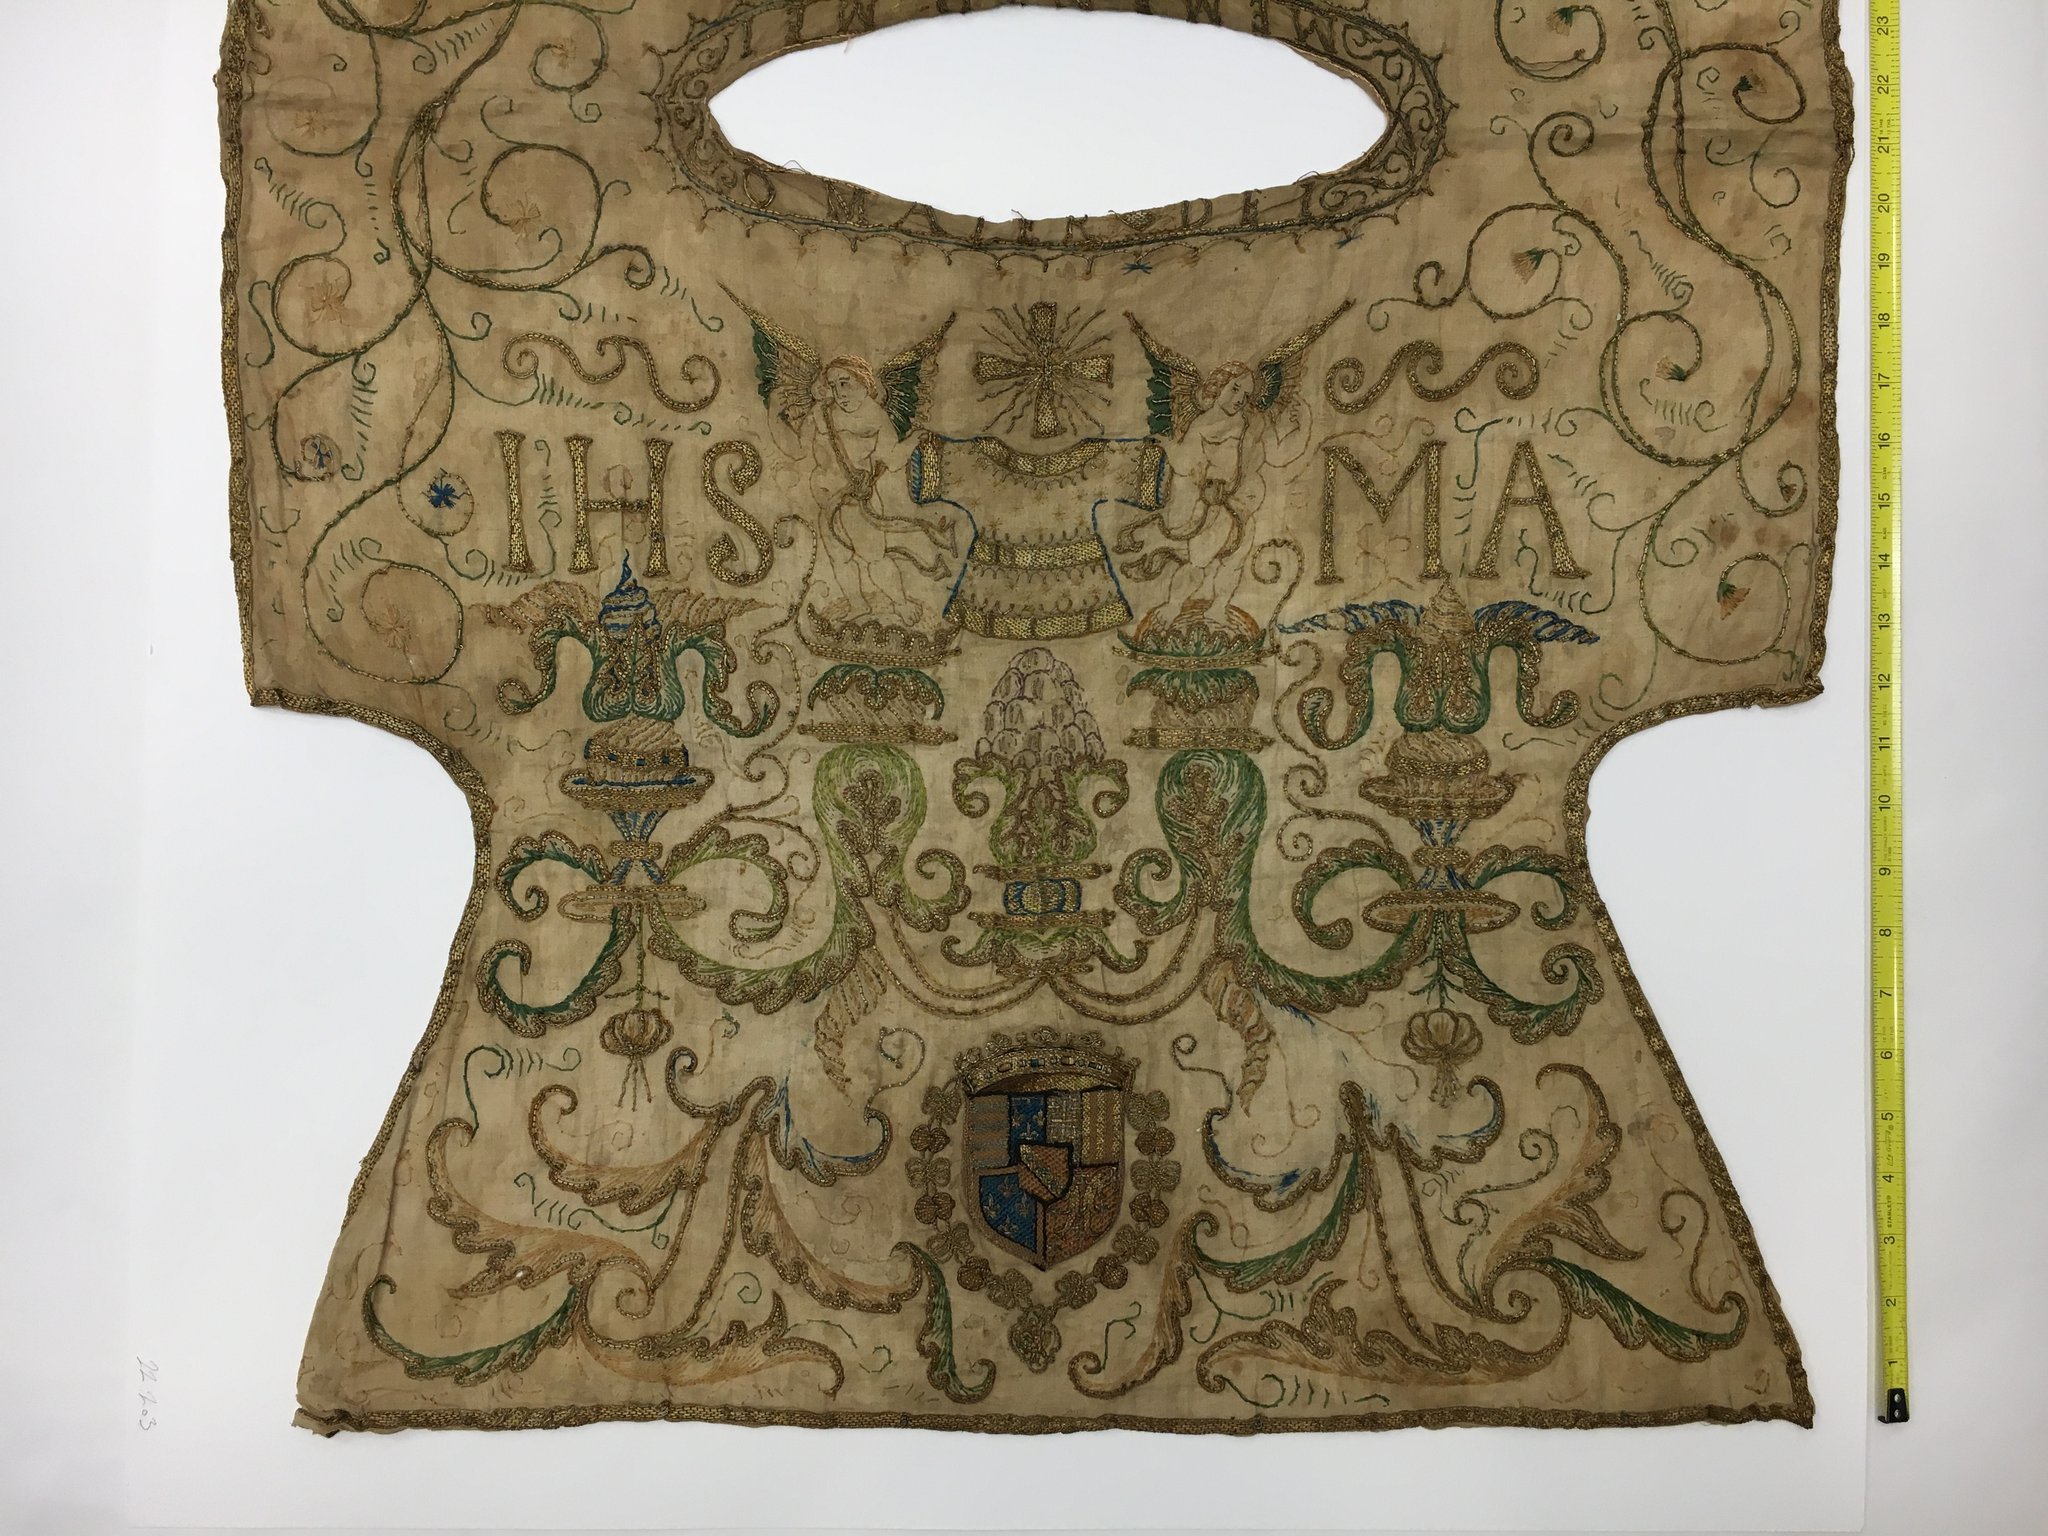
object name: statue robe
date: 1501-1533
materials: linen, metal thread, silk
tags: angels,cross,coat of arms